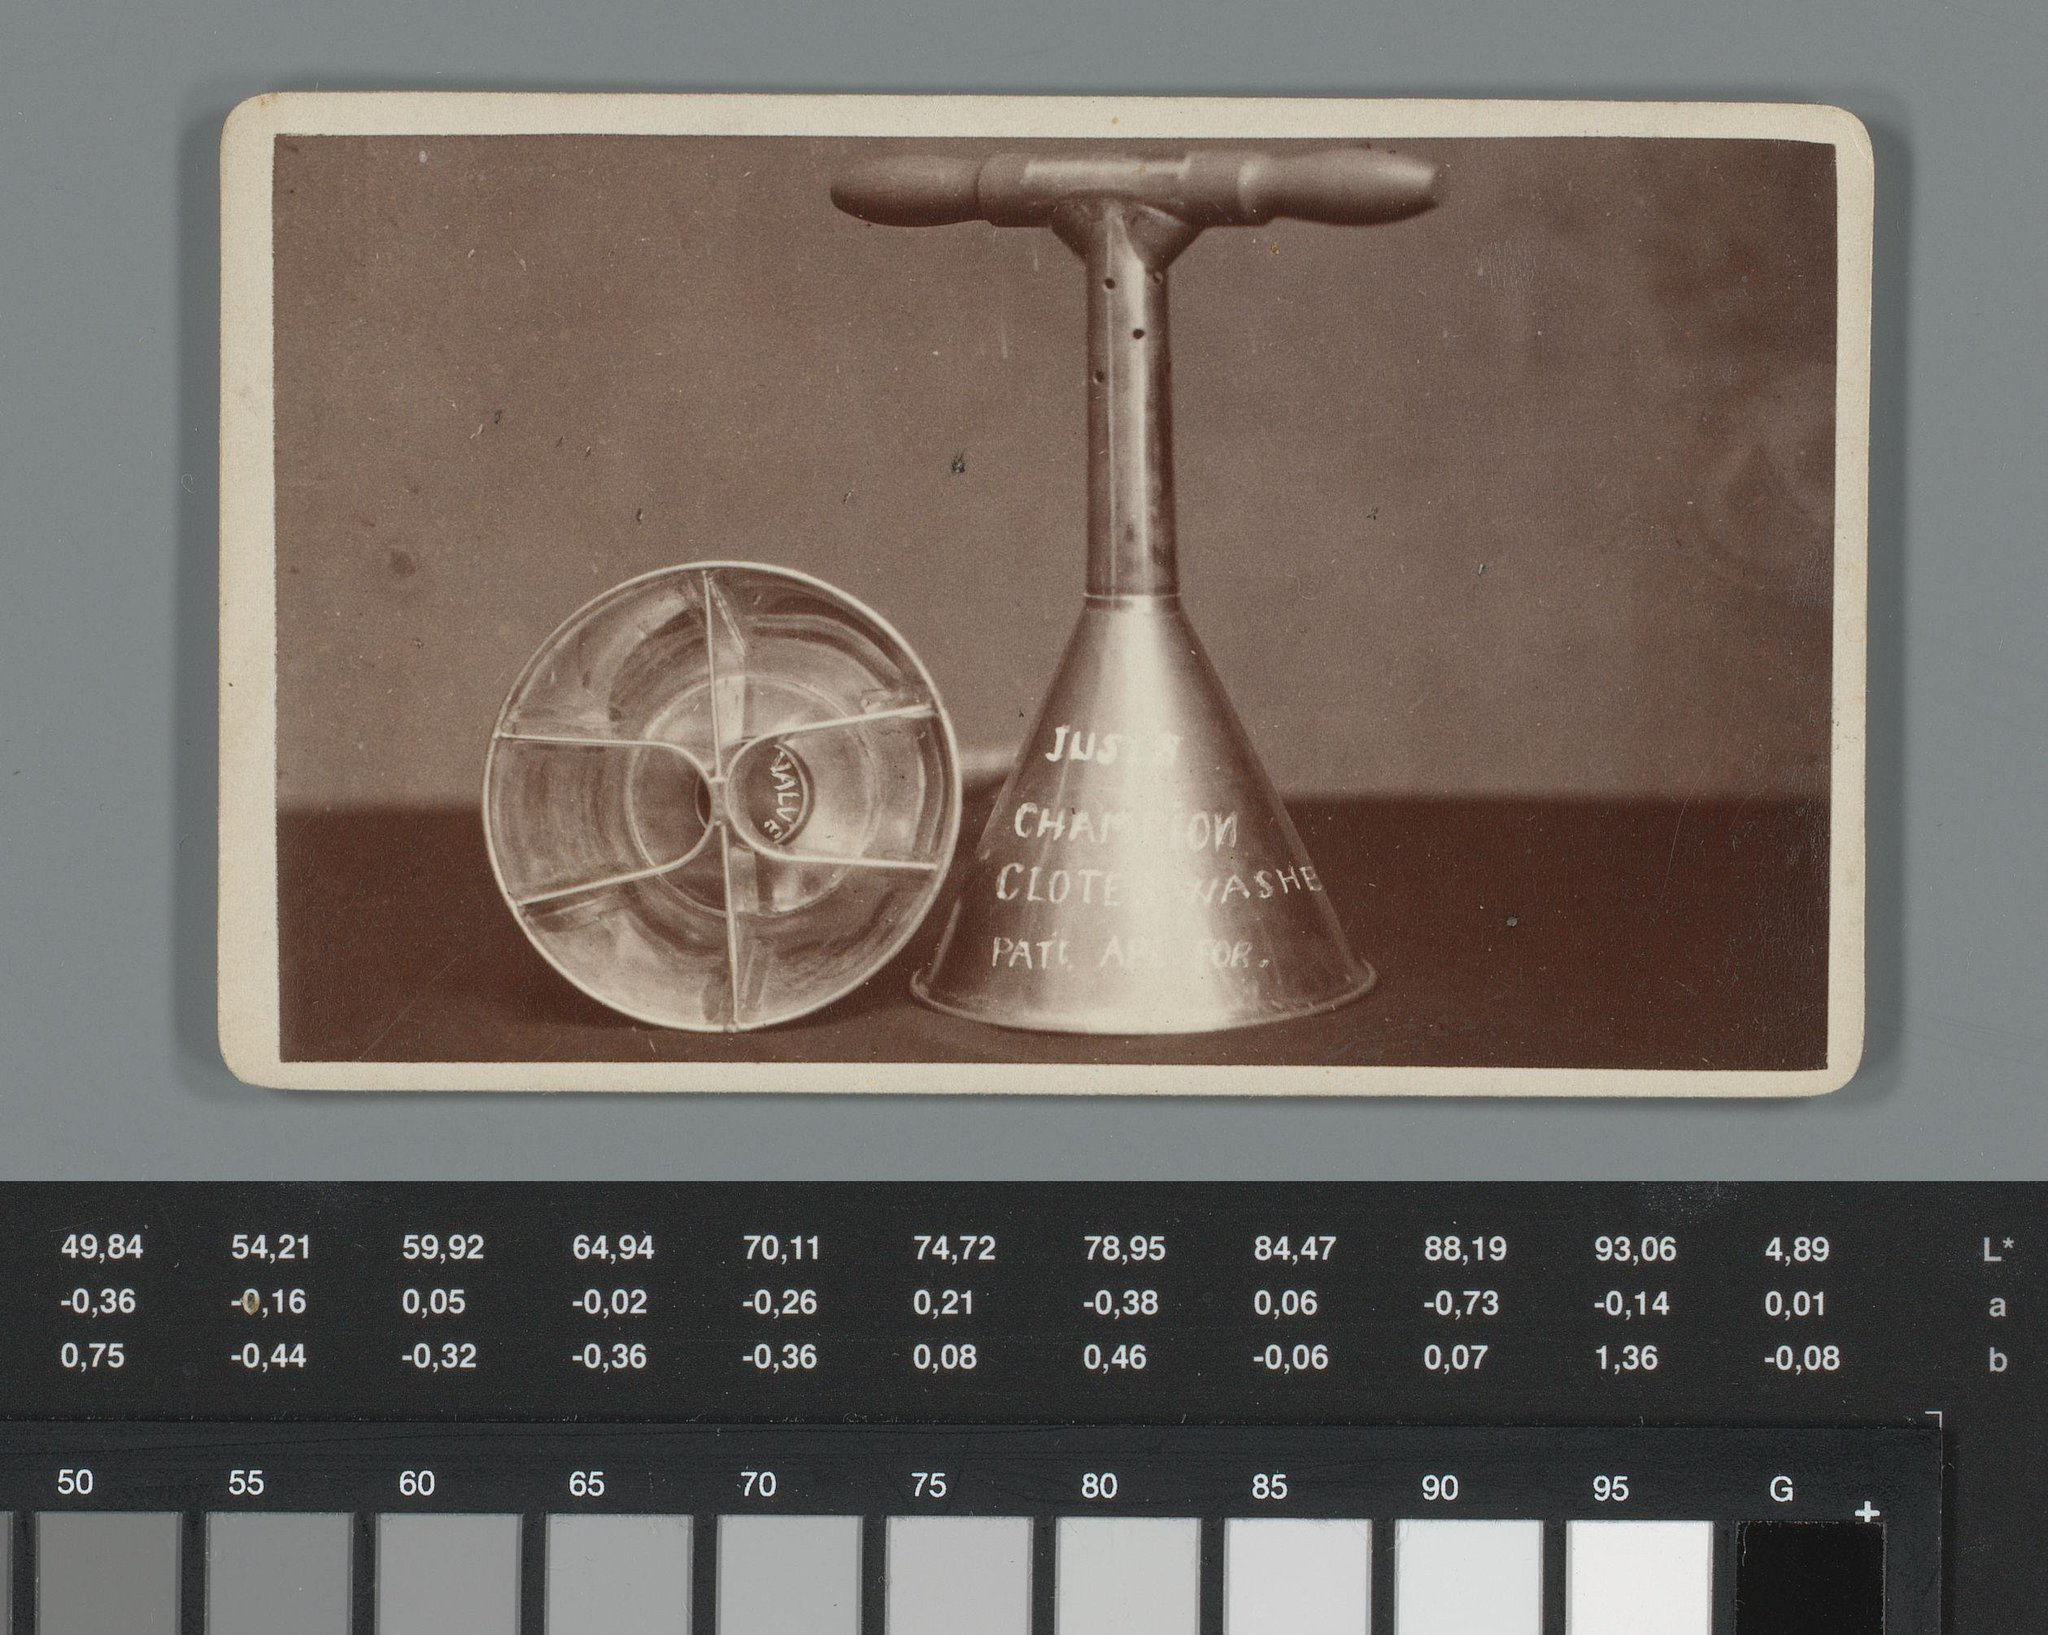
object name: carte de visite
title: Reclame met voorwerp om kleding mee te wassen van Just's Champion in Fauk City, Wisconsin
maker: p. j. schadde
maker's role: fotograaf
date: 1870-1915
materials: cardboard, photographic support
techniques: carbon print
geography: wisconsin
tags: tools, aids, implements ~ crafts and industries, advertising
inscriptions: inscription: ‘THE WESTRN PHOTOGRAPH COPYING HOUSE/ OF/ P. J. SCHADDE./ PHOTOGRAPHER,/ SAUK CITY, WISCONSIN (...)’